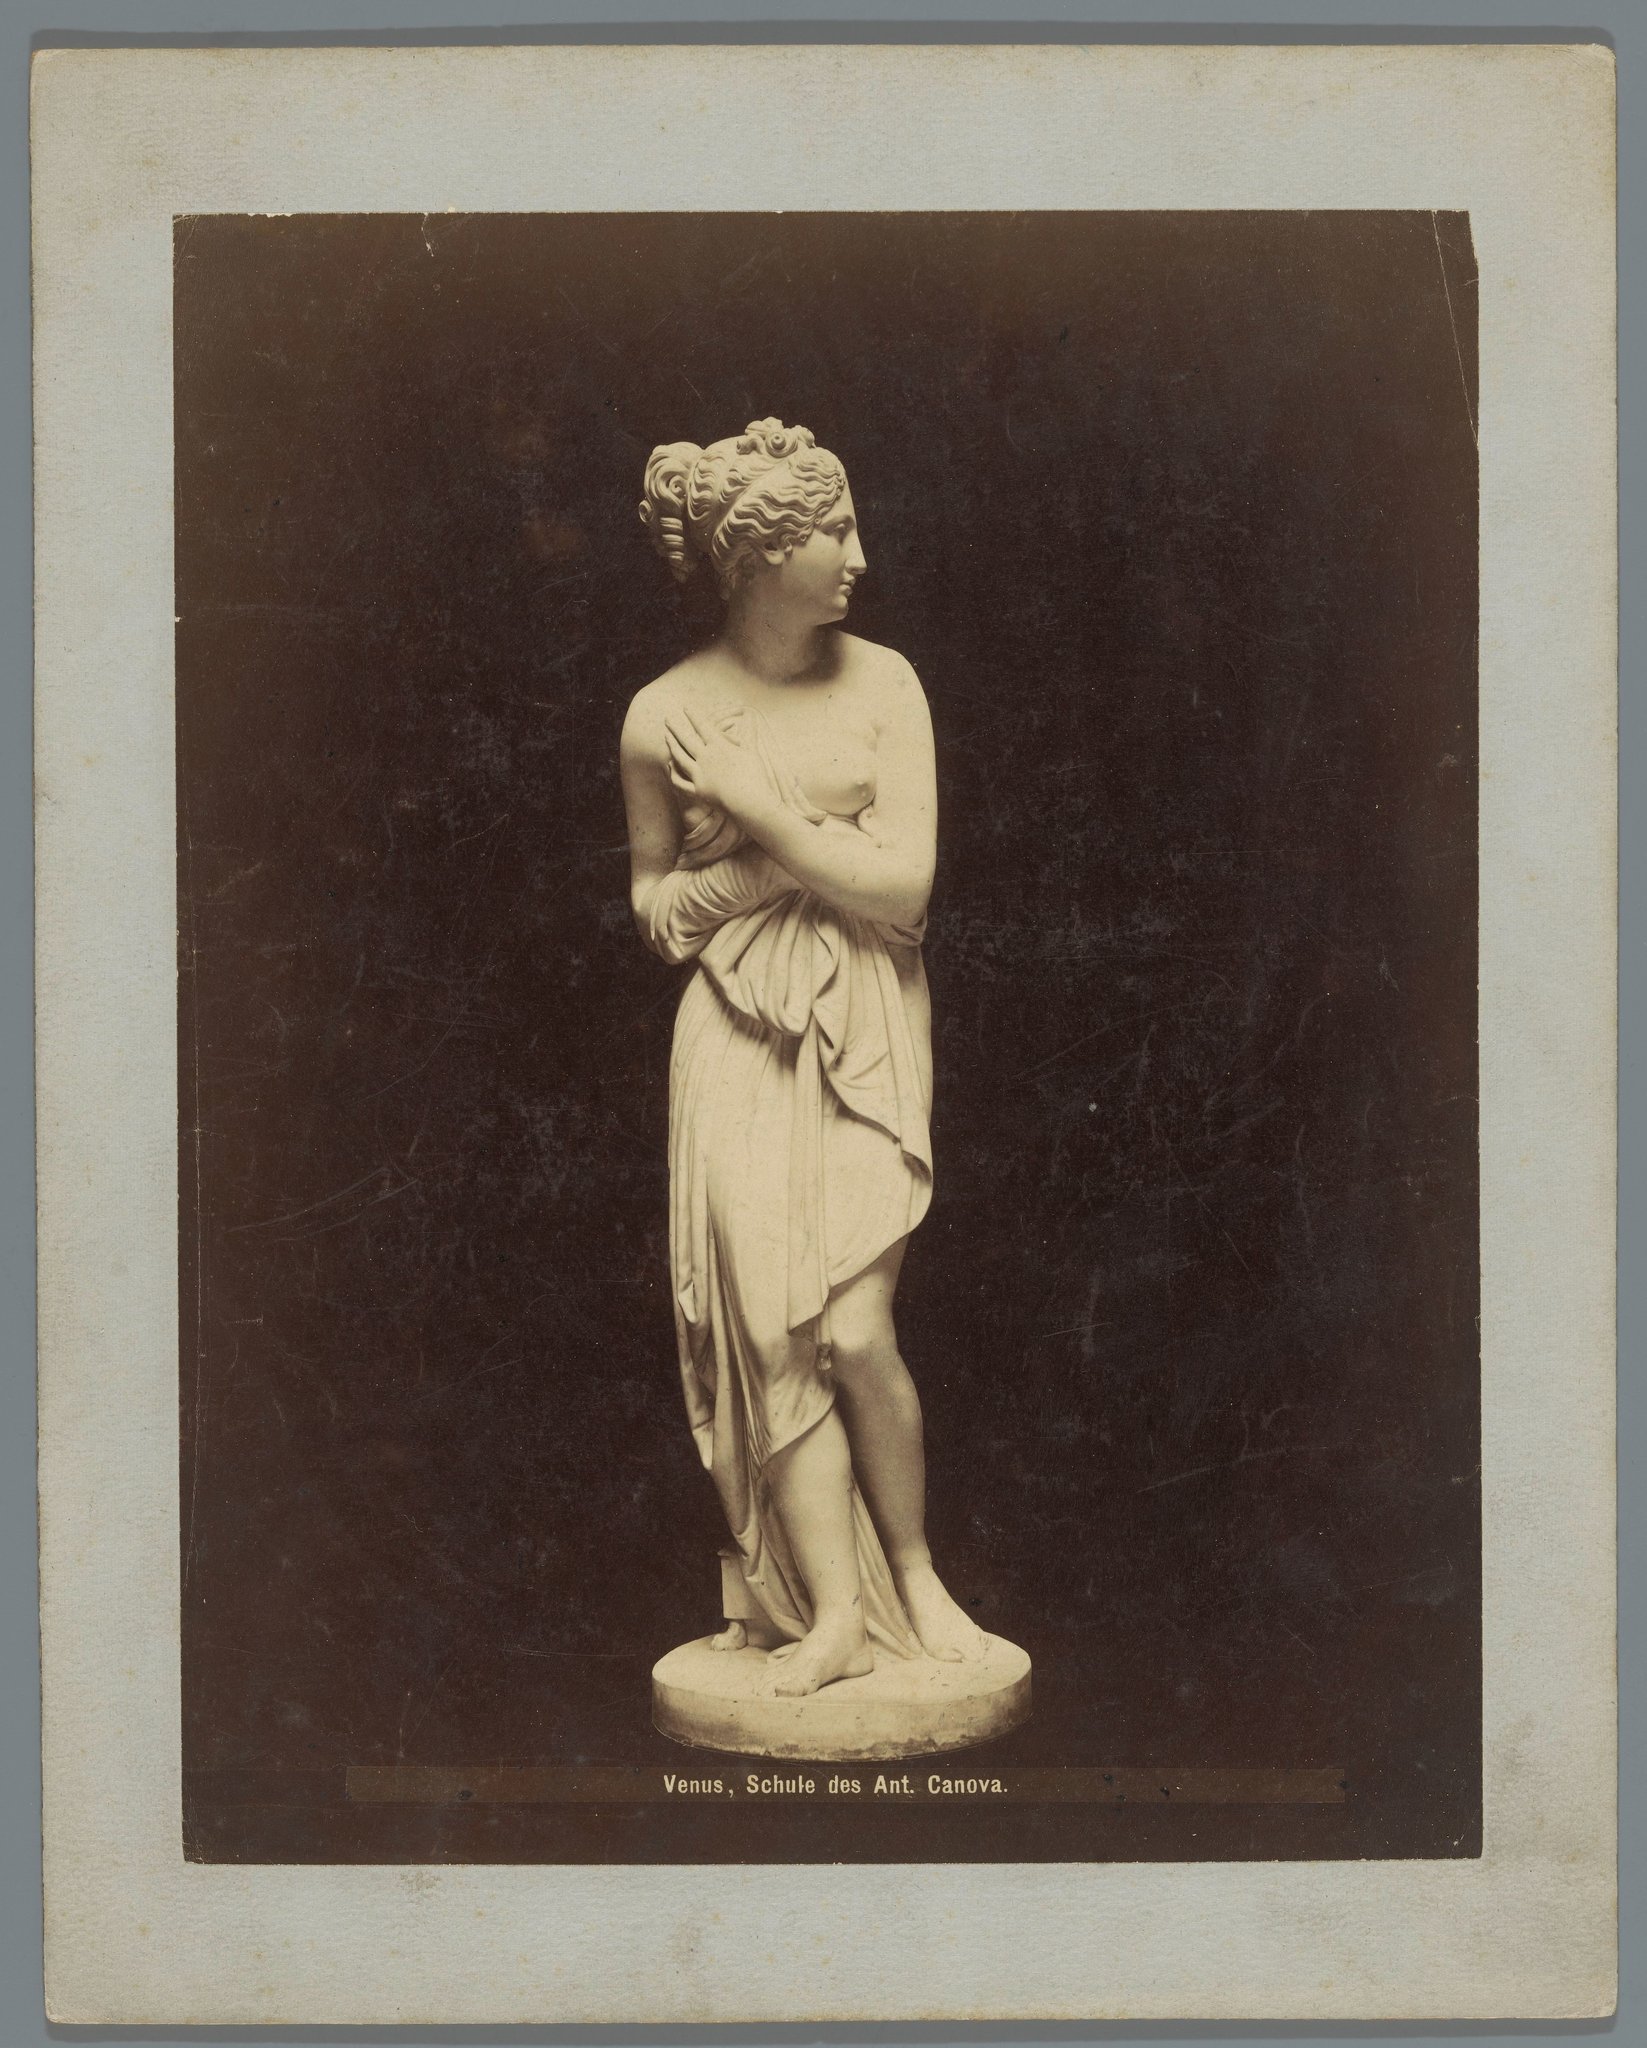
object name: photograph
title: Venus, Schule des Ant. Canova.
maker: Anonymous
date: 1875-1900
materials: cardboard, photographic support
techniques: albumen print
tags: monument, statue, (story of) venus (aphrodite)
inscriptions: collector's mark: Lugt 3937, name: ‘J. Löroy k. k. Hof-Photograph WIEN’